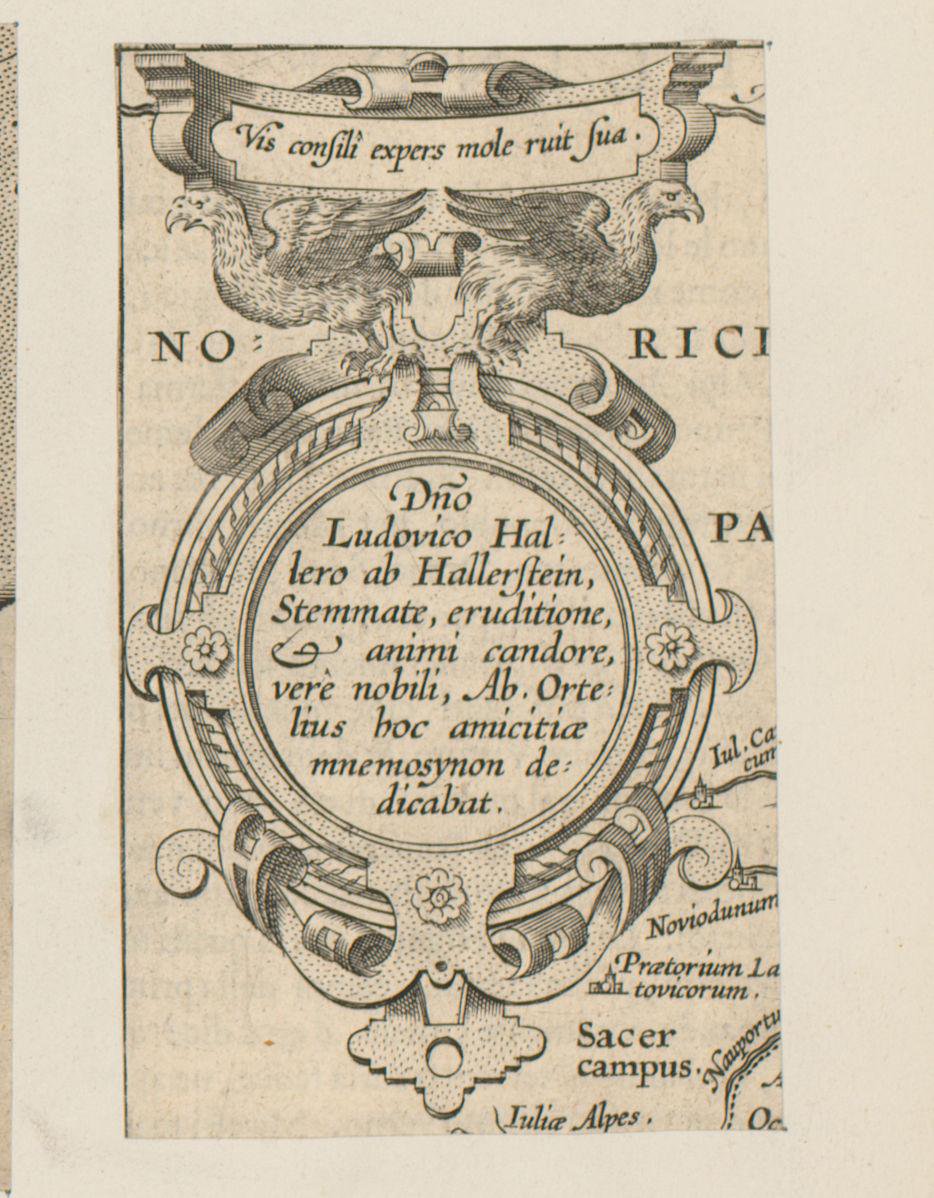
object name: print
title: Rechthoekige cartouche met een tros fruit, vogels en maskers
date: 1590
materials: paper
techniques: engraving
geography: antwerp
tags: fruits and vegetables ~ ornament, birds, ornament ~ cartouche, mask, mascaron ~ ornament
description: Rechthoekige cartouche met een tros fruit, vogels en maskers. De cartouche is een fragment van een kaart van Frankrijk. De prent maakt deel uit van een album.